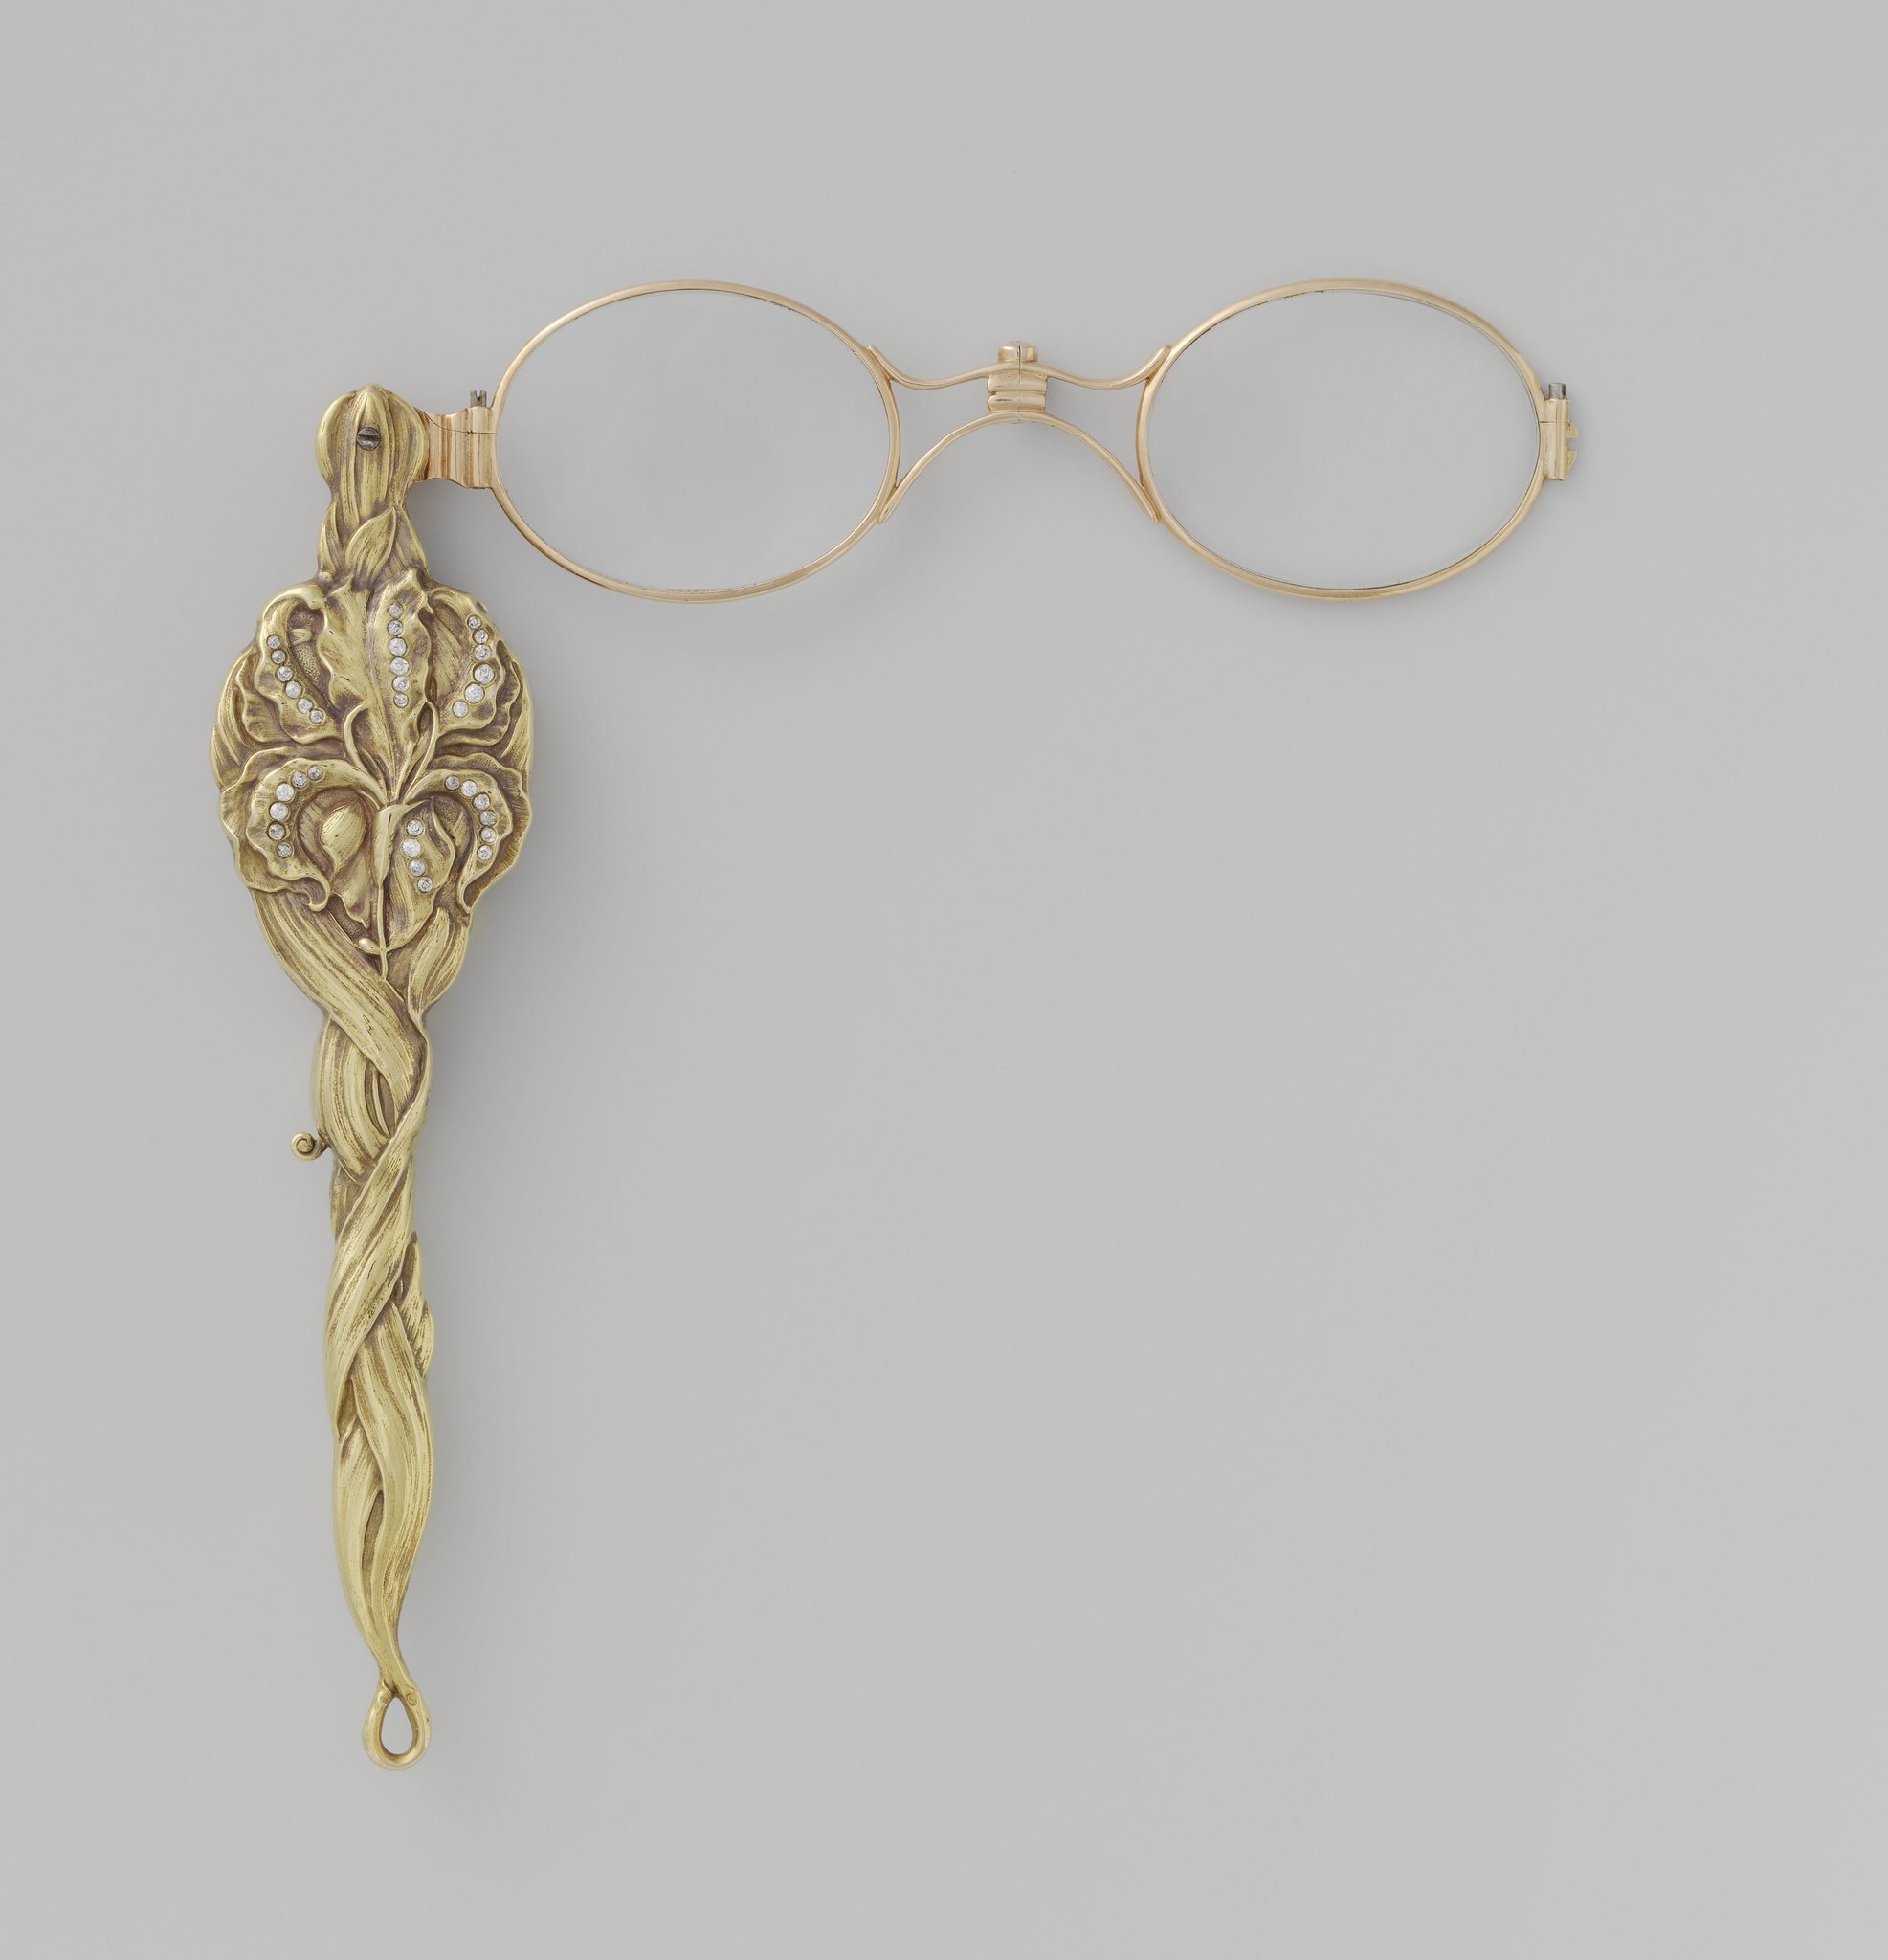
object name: jewellery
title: Lorgnette (face–à-main)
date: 1900-1910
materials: diamond, glass, gold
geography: new york city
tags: flowers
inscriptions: alloy mark: ‘585 in ovaal (Nederland, vanaf 1955)’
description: Around 1900 French fashion set the tone everywhere. In the United States, large jewellery houses, such as Tiffany & Co. in New York, were instrumental in disseminating it. Not only did they sell French wares, they also had objects designed locally that emulated the form and decoration of French models. A typical example is this lorgnette, which, when folded, looks like an iris in bloom.